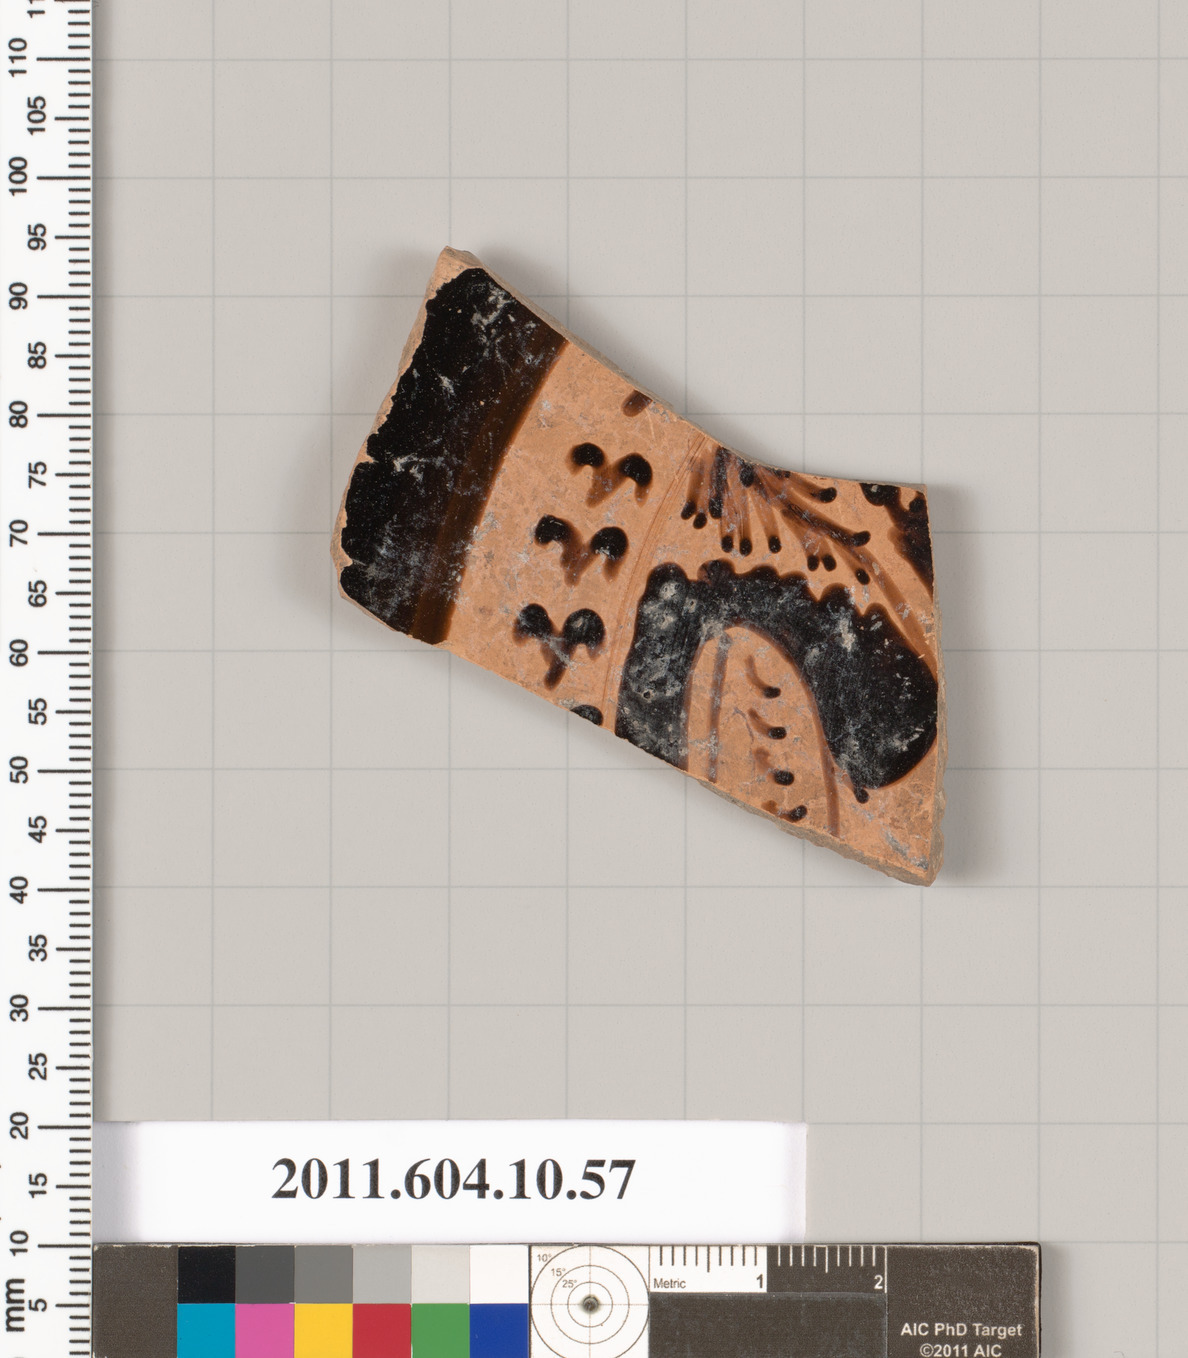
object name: kylix fragment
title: Terracotta fragment of a kylix (drinking cup)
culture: etruscan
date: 334-301 BCE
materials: terracotta